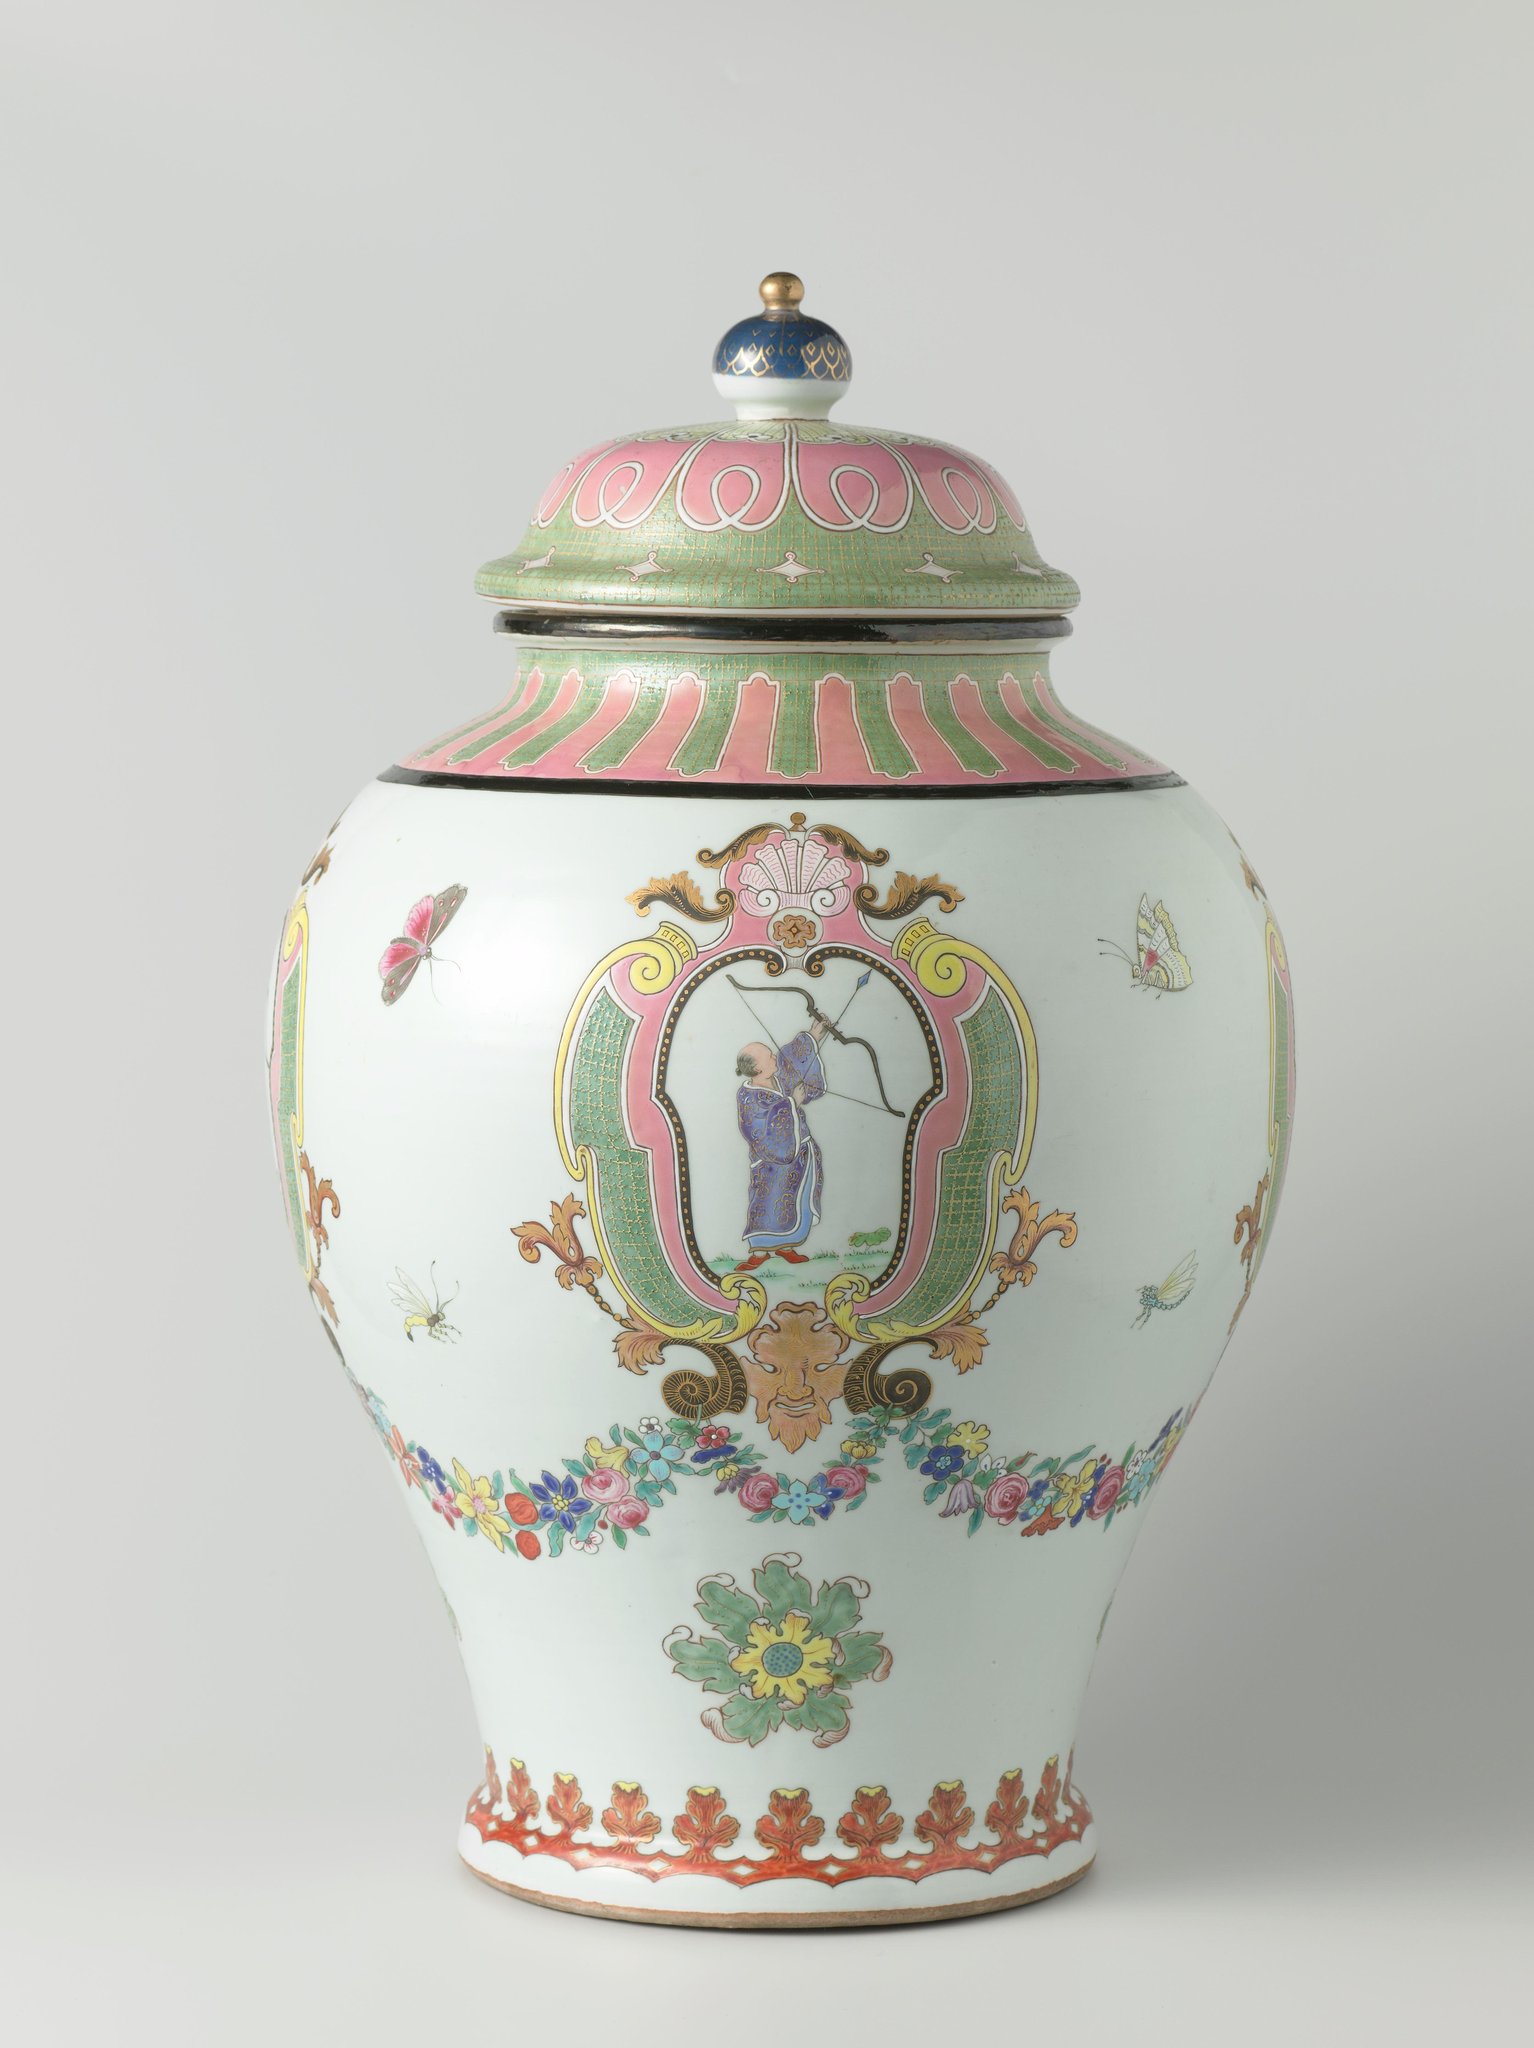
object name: fonteinpot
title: Fountain jar with an image of The Archer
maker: Anonymous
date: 1740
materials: glaze, gold, paint, porcelain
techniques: firing, gilding, turning, vitrification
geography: netherlands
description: Balustervormige urn of watervat op een platte, ongeglazuurde basis met een brede rand. Een gewelfd deksel met een knop. Net boven de voet is een opening aangebracht voor een tapkraantje. Gedecoreerd in emailkleuren. Op de zijden vier cartouches met daarin een Chinese boogschutter, elk cartouche heeft bovenaan een schelp, onderaan een masker. De cartouches worden met elkaar verbonden door een bloemslinger. Verder versierd met vlinders, rond de tap een rozet. Op de schouder en deksel een decoratief lambrequin-patroon. Het ontwerp van de Boogschutter zou één van de ontwerpen kunnen zijn die Cornelis Pronk (1691-1754) tussen 1734 en 1736 maakte in opdracht van de VOC. Twee ontwerpen kunnen met zekerheid aan hem worden toegeschreven, namelijk de Parasoldames (zie bijvoorbeeld AK-RBK-15939) en de Doctoren (zie bijvoorbeeld AK-NM-13703): de tekeningen hiervan bevinden zich in het Rijksprentenkabinet te Amsterdam. Het vierde ontwerp is het Prieel (zie bijvoorbeeld AK-NM-13528). Van dit ontwerp is geen tekening bewaard gebleven, maar het is beschreven in de VOC-archieven. Het ontwerp van de Boogschutter zou het derde ontwerp kunnen zijn, het is echter alleen de stijl van het ontwerp waarop deze mening is gebaseerd.